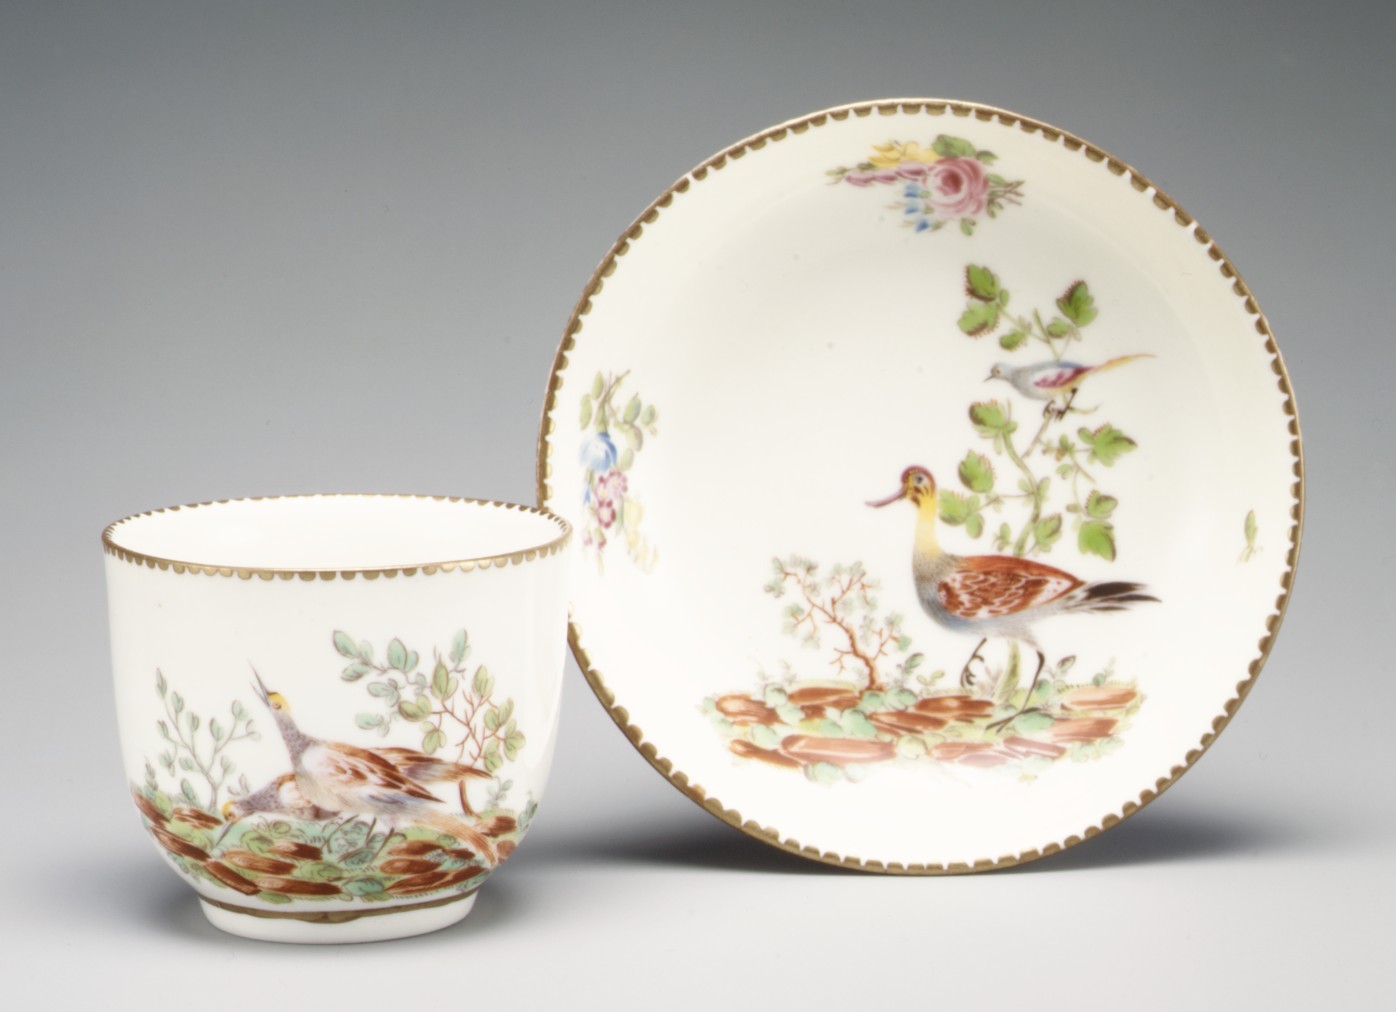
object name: cup and saucer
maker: chantilly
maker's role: factory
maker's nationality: french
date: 1760-1765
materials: soft paste porcelain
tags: birds,flowers